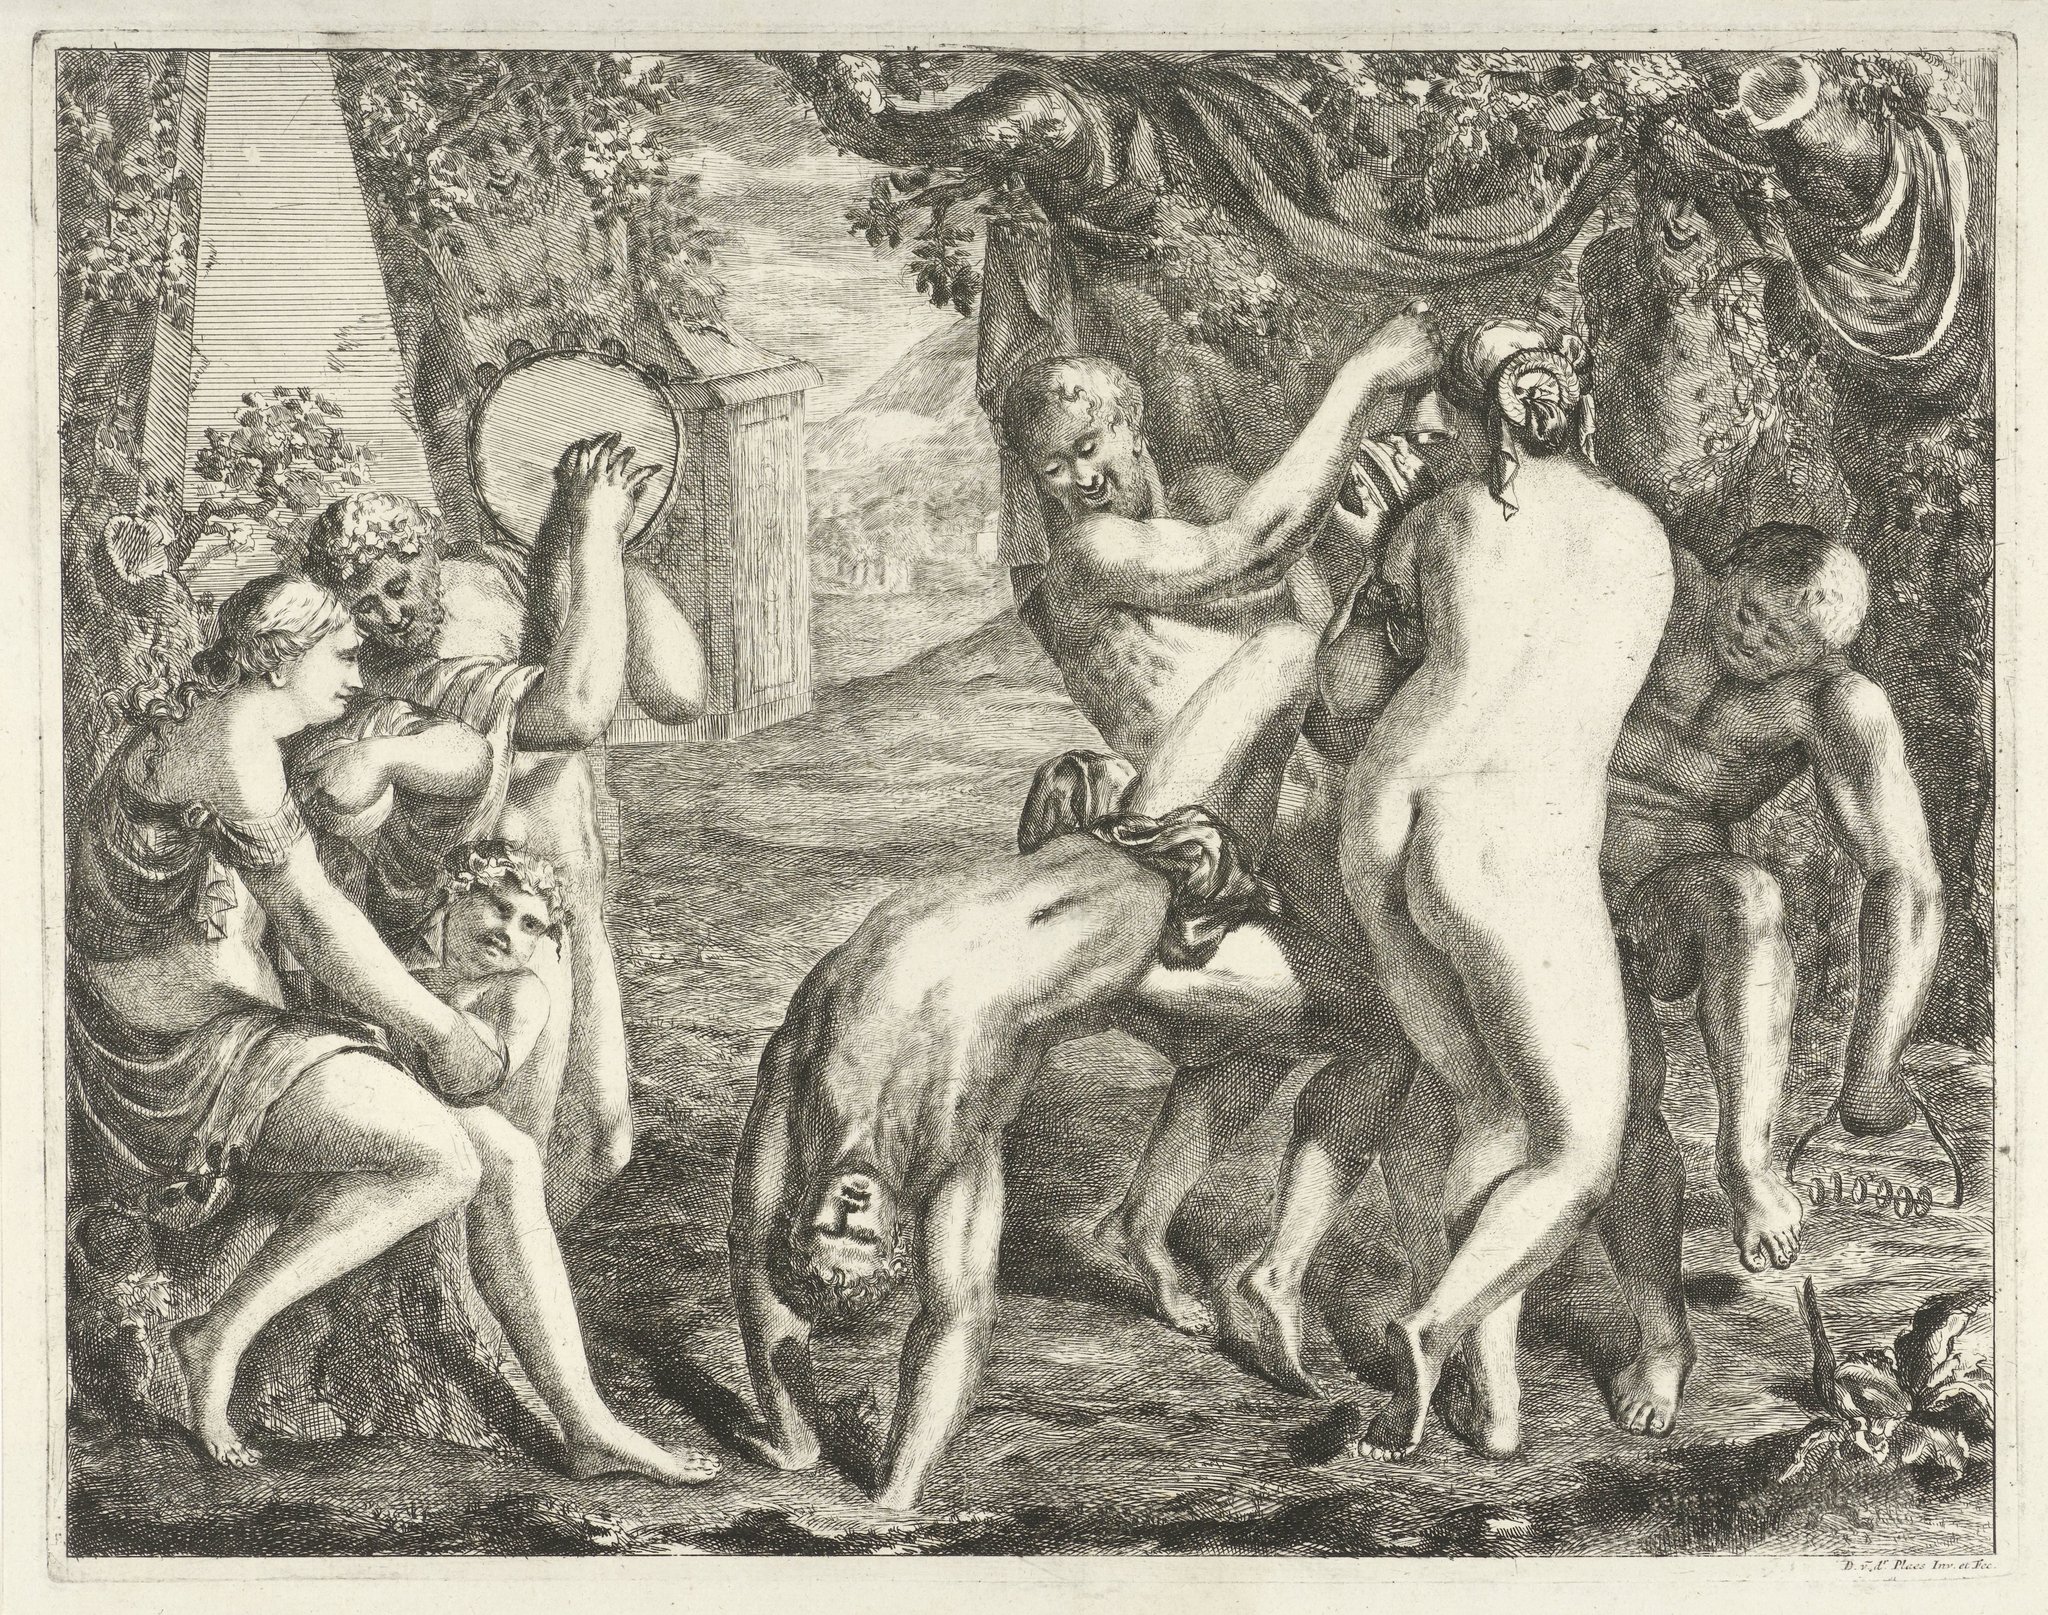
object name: print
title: Landschap met een bacchanaal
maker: david van der plas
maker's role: draughtsman, painter, print maker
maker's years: 1647-1704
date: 1667-1704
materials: paper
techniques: engraving, etching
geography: amsterdam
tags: tambourine - cc - out of doors, thiasos, i.e. bacchus' revel-rout, bacchanal without bacchus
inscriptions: collector's mark: Lugt 2228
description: Een bacchanaal met feestende bacchanten en meanaden. Ze dansen en maken muziek. Eén van hen springt achterover.